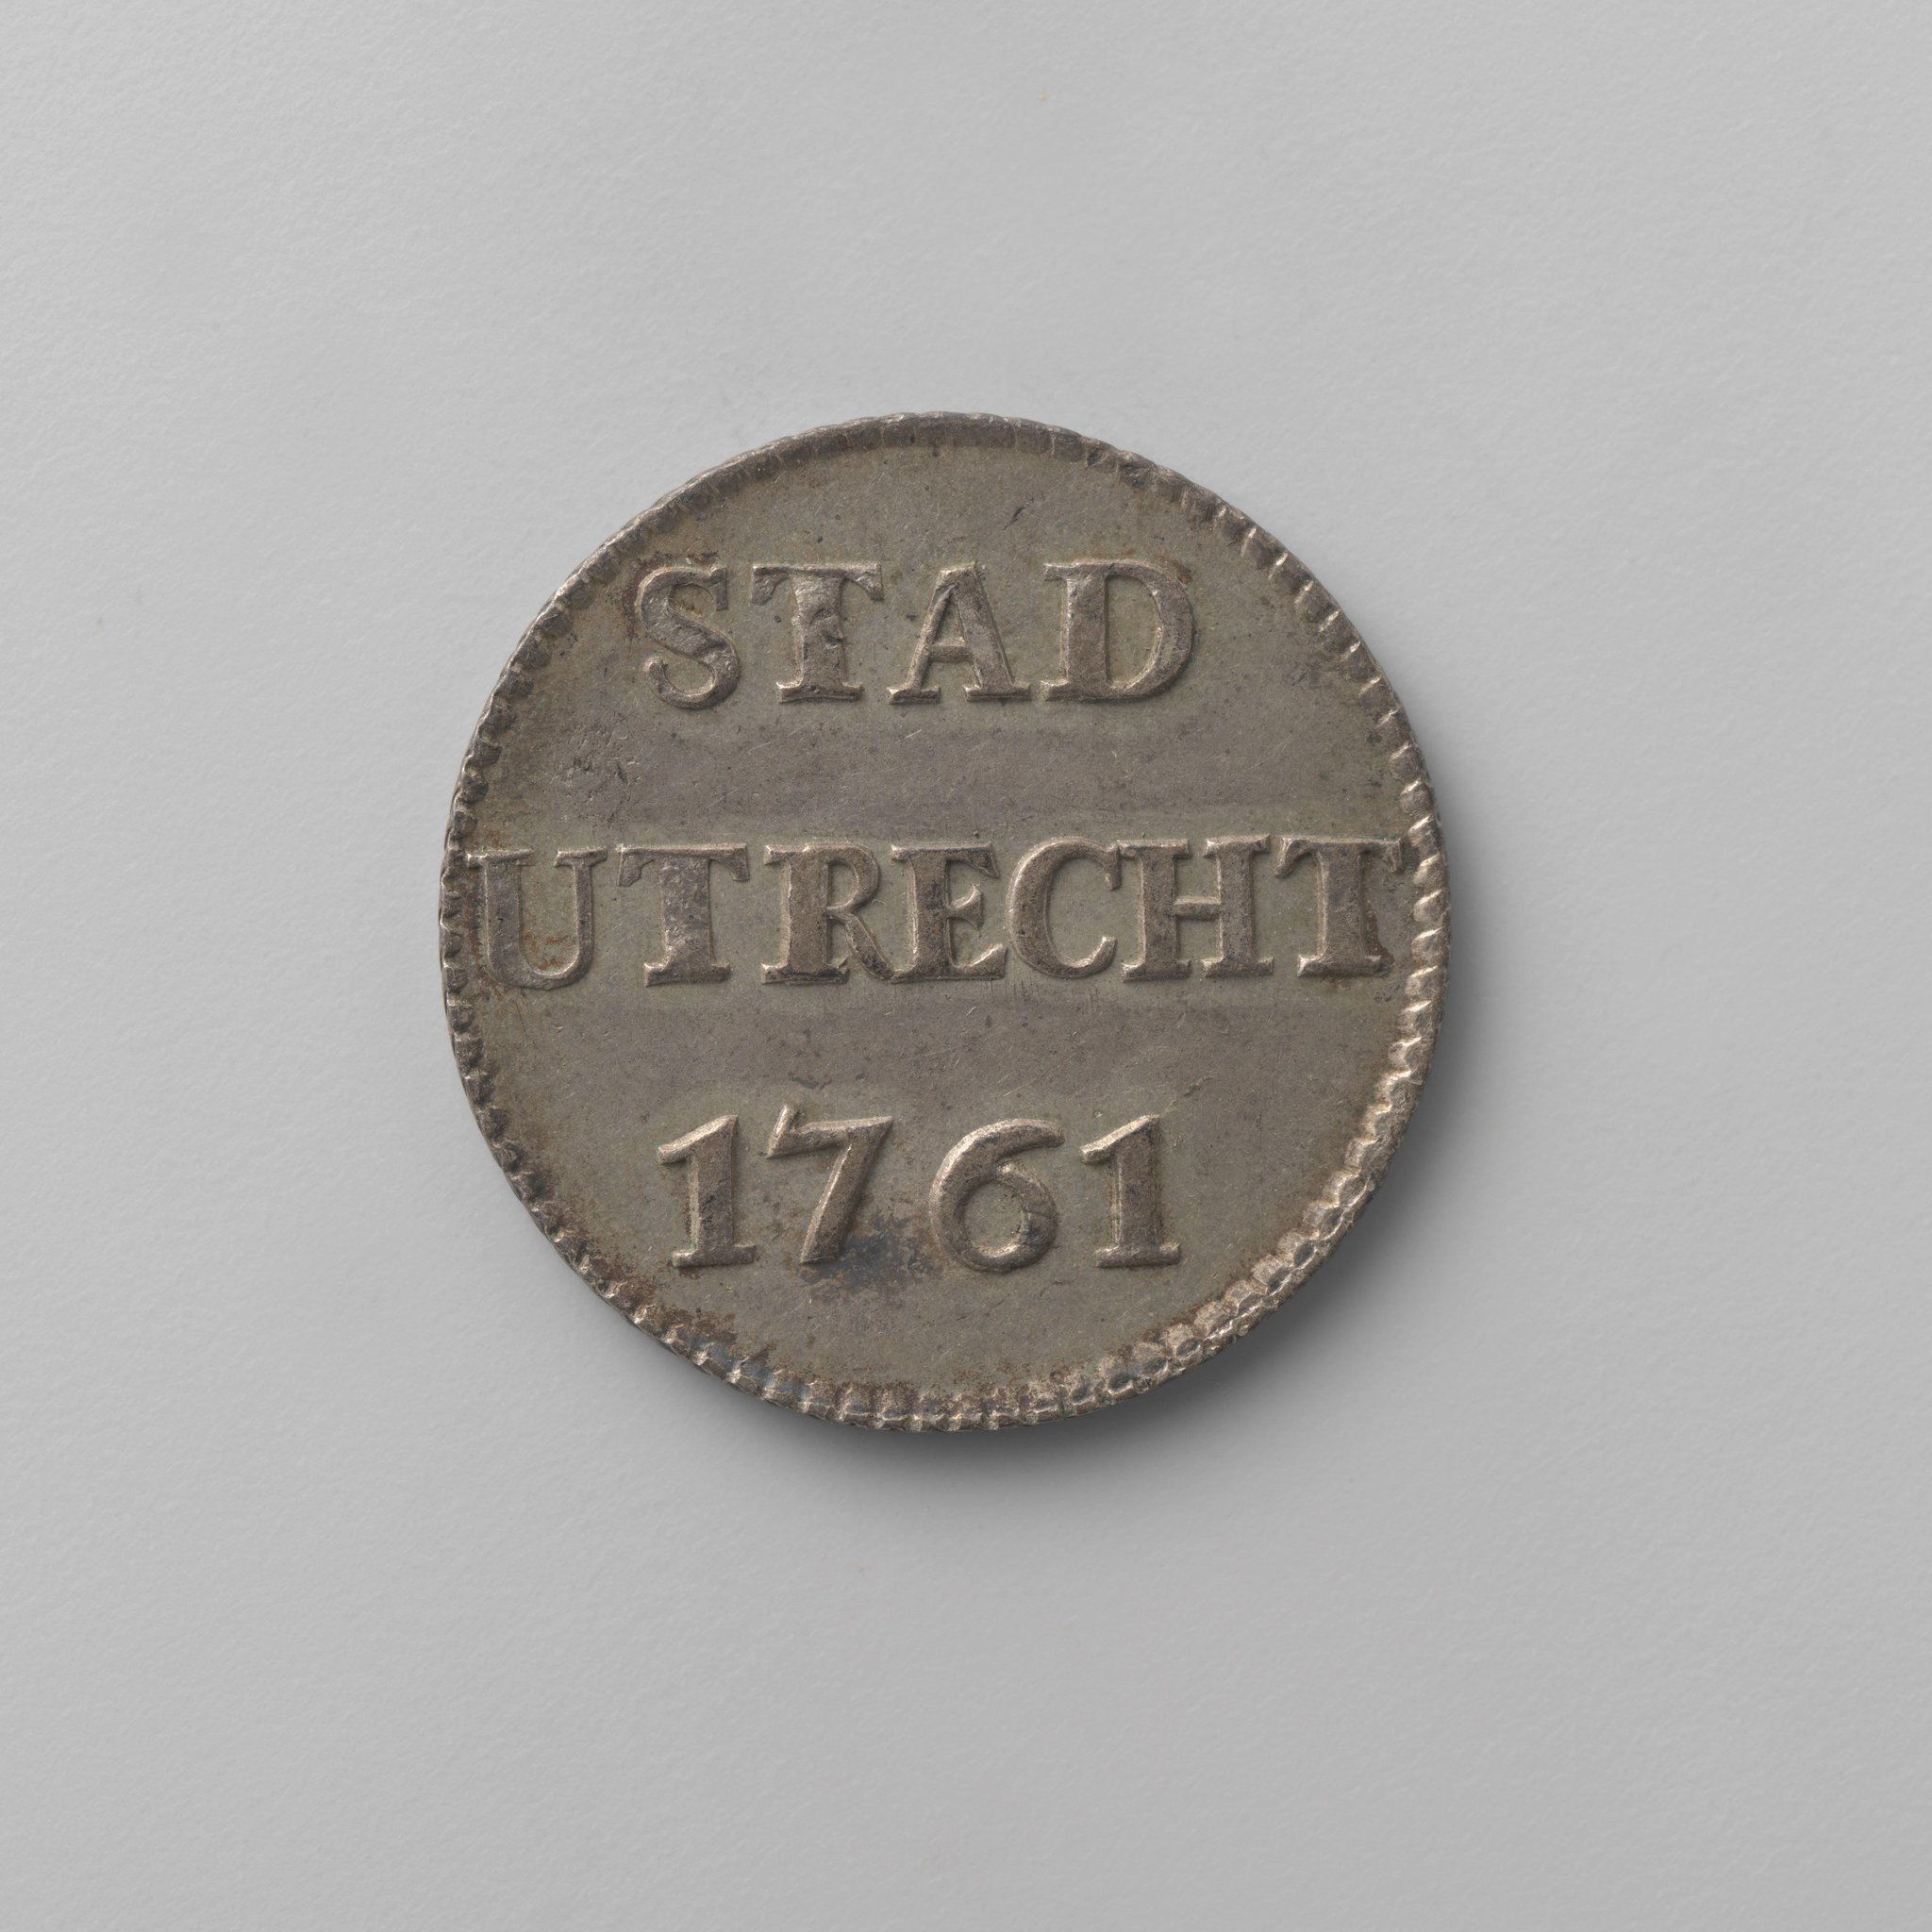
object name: coin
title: Stad Utrecht, duit, 1761. Afslag in zilver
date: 1761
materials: silver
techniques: striking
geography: utrecht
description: Zilveren munt. Voorzijde: gekroond stedelijk wapenschild, gehouden door twee leeuwen met in afsnede dikke lijn, waaronder een versierde accolade met een grote schelp. Keerzijde: opschrift in twee regels, waaronder jaartal. Jaartal met Arabischse 1. Afslag in zilver. Kabelrand.